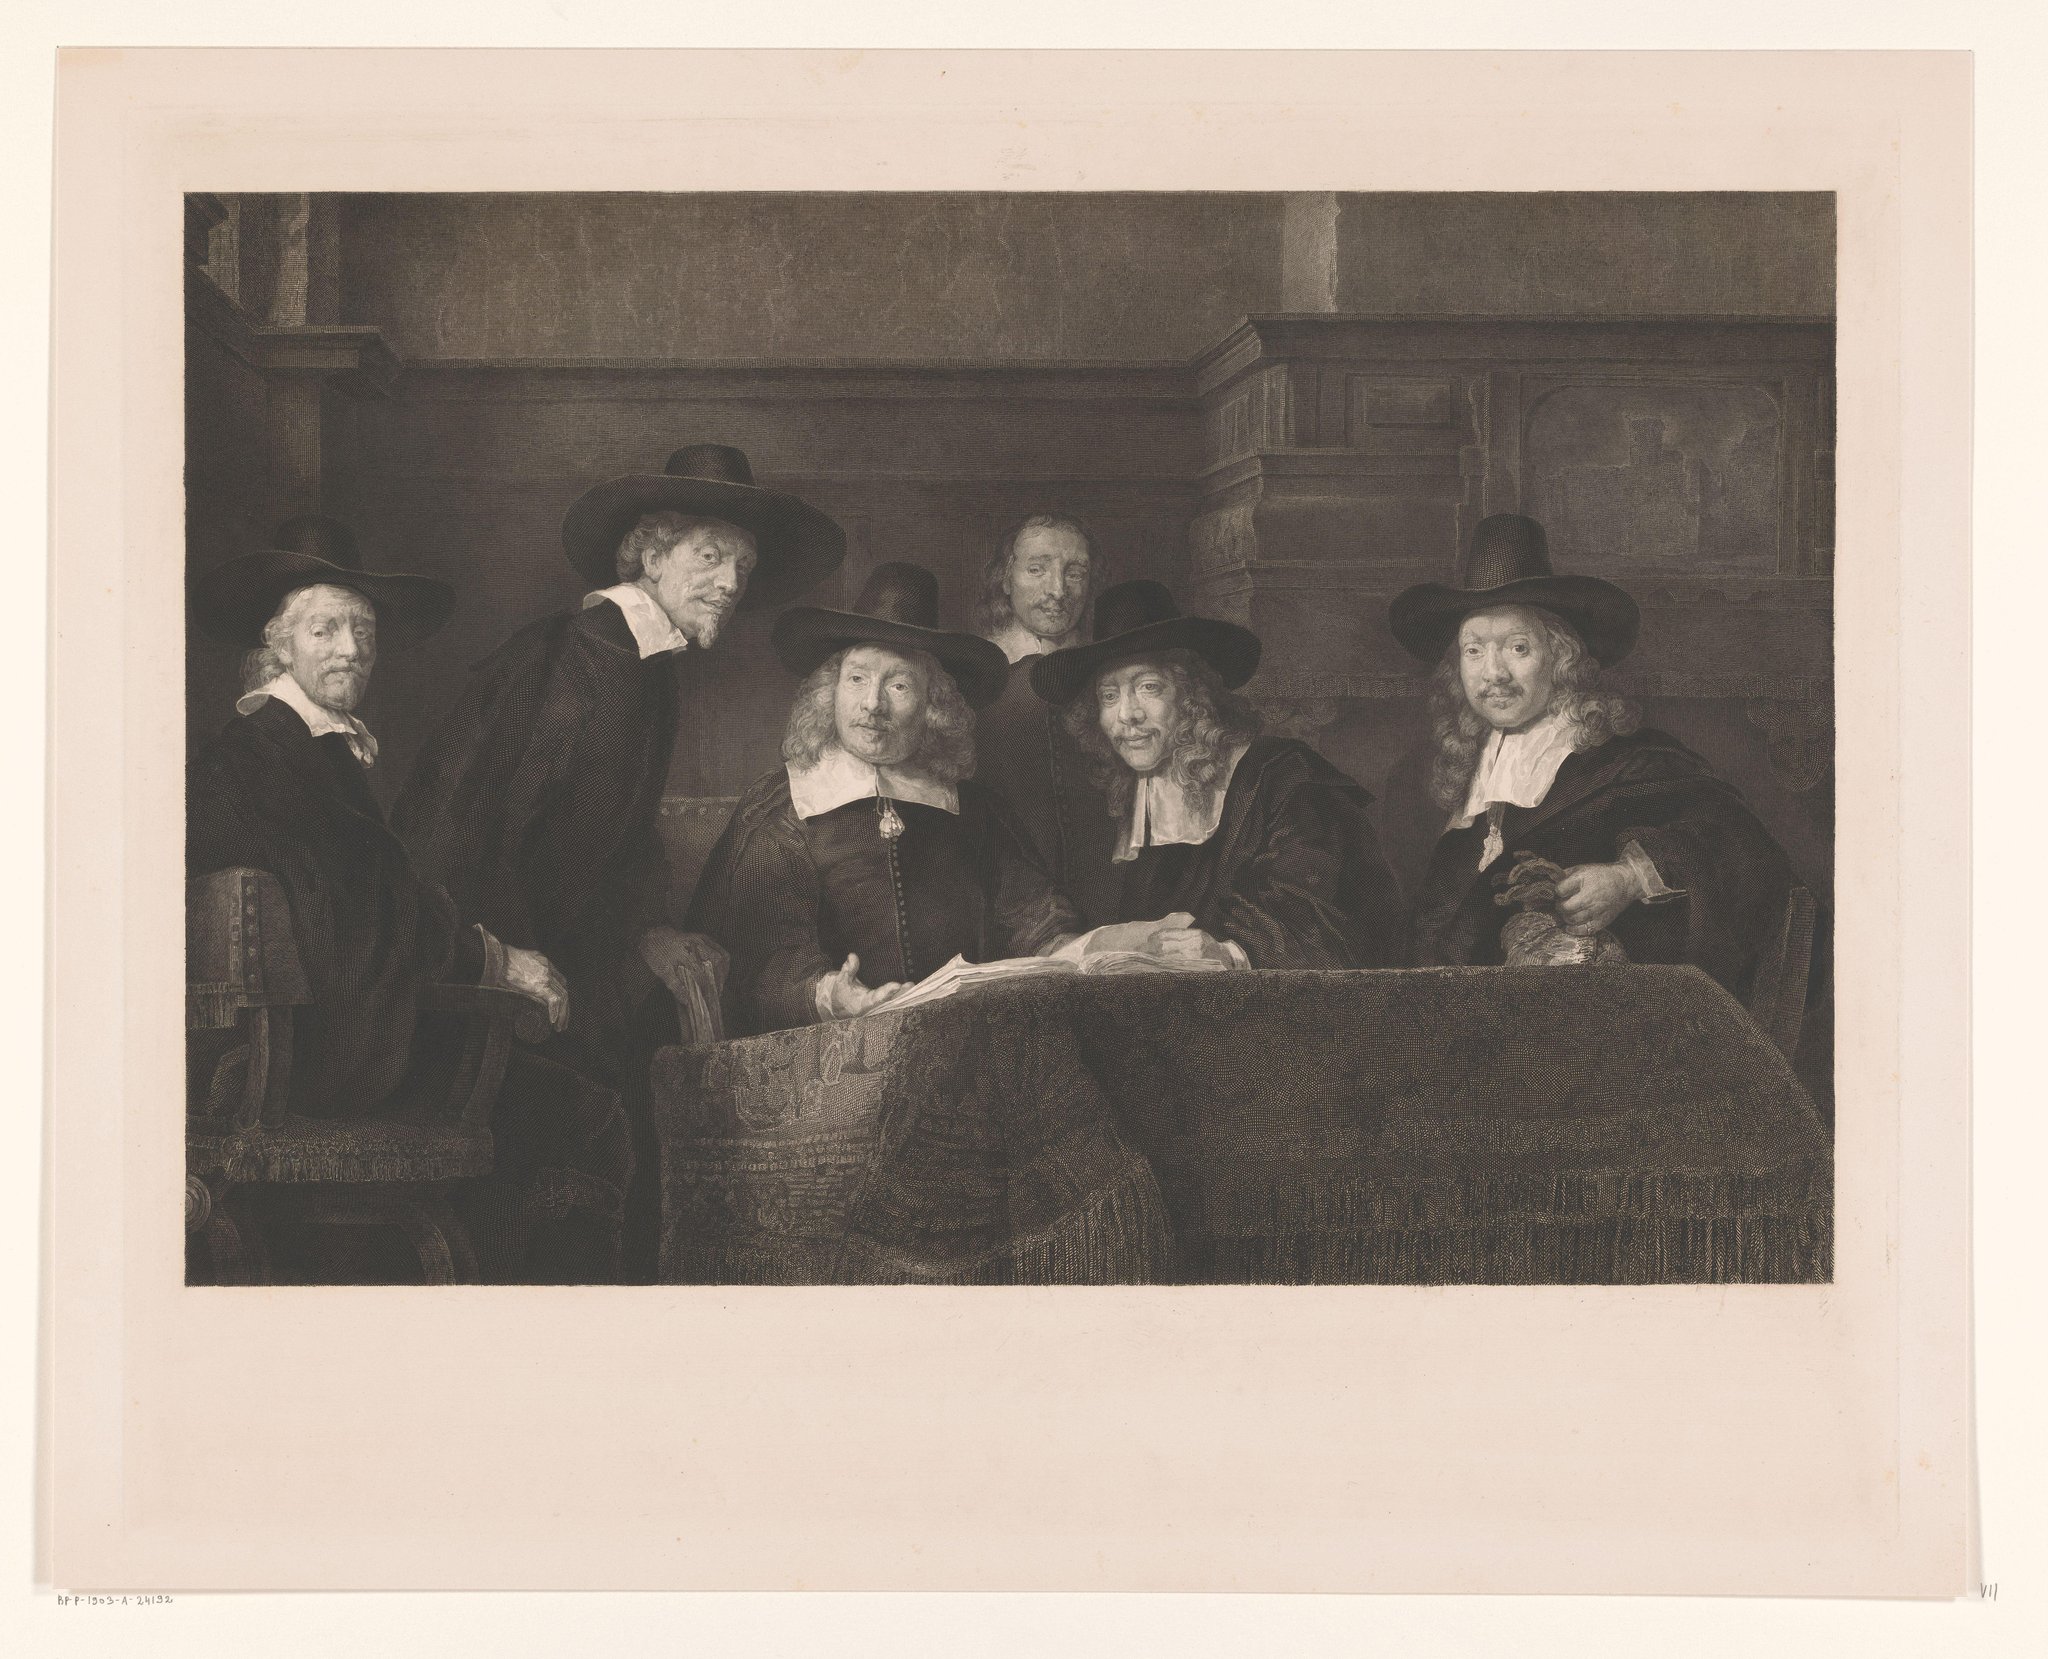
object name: print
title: De waardijns van het Amsterdamse lakenbereidersgilde, bekend als ‘De Staalmeesters’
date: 1846-1900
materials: paper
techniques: engraving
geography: netherlands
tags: control of quality, amsterdam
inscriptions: collector's mark: Lugt 2228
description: De Staalmeesters: het college van staalmeesters of waardijns van het Amsterdamse lakenbereidersgilde, bijeen rond een tafel waarop een Perzisch kleed ligt. Op tafel het opengeslagen stalenboek. Voorgesteld zijn van links naar rechts: Jochem de Neve (1629-81), Aernout van der Mye (ca. 1625-81), de knecht Frans Hendricksz Bel (1629-1701), Willem van Doeyenburg (ca. 1616-87), Volckert Jansz (1605/10-81), Jacob van Loon (1595-1674). Links boven de haard een schilderij met een brandend baken.